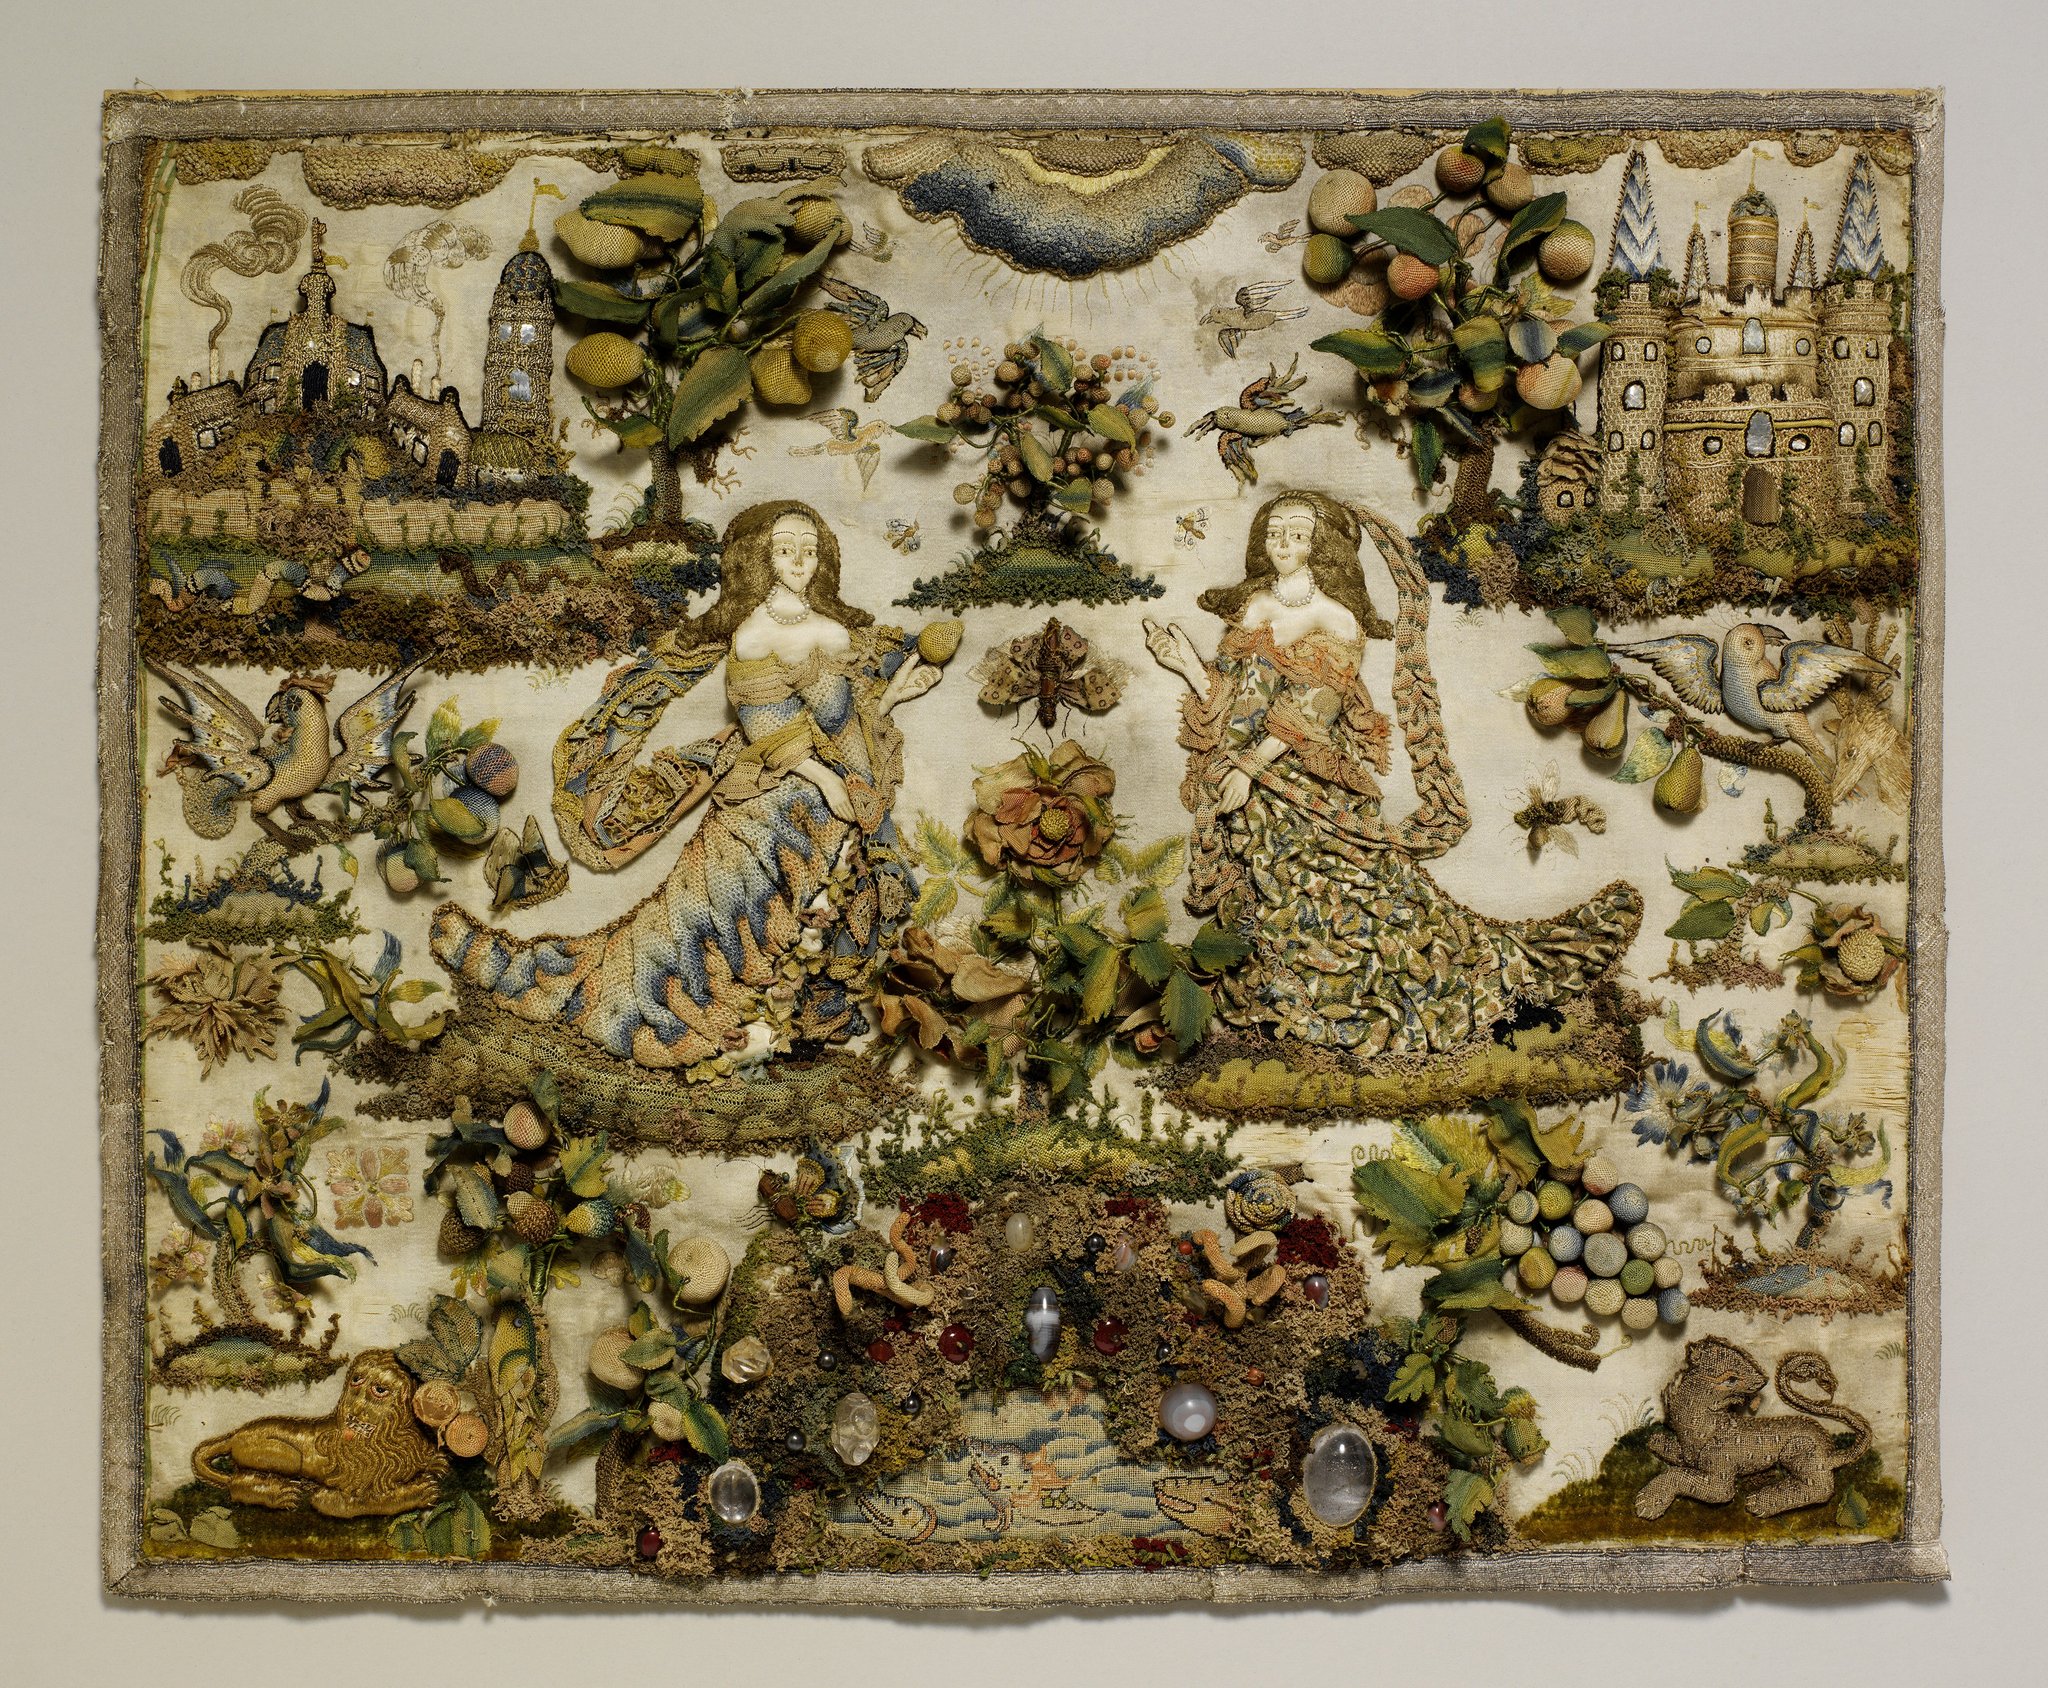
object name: embroidered picture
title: Two Ladies Personifying Taste and Touch (?)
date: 1651-1675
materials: stone, gemstone, coral, glass, metal thread, mica, pearl, quartz, textile, silk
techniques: embroidery, stitching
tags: birds,castles,fruit,women,lions